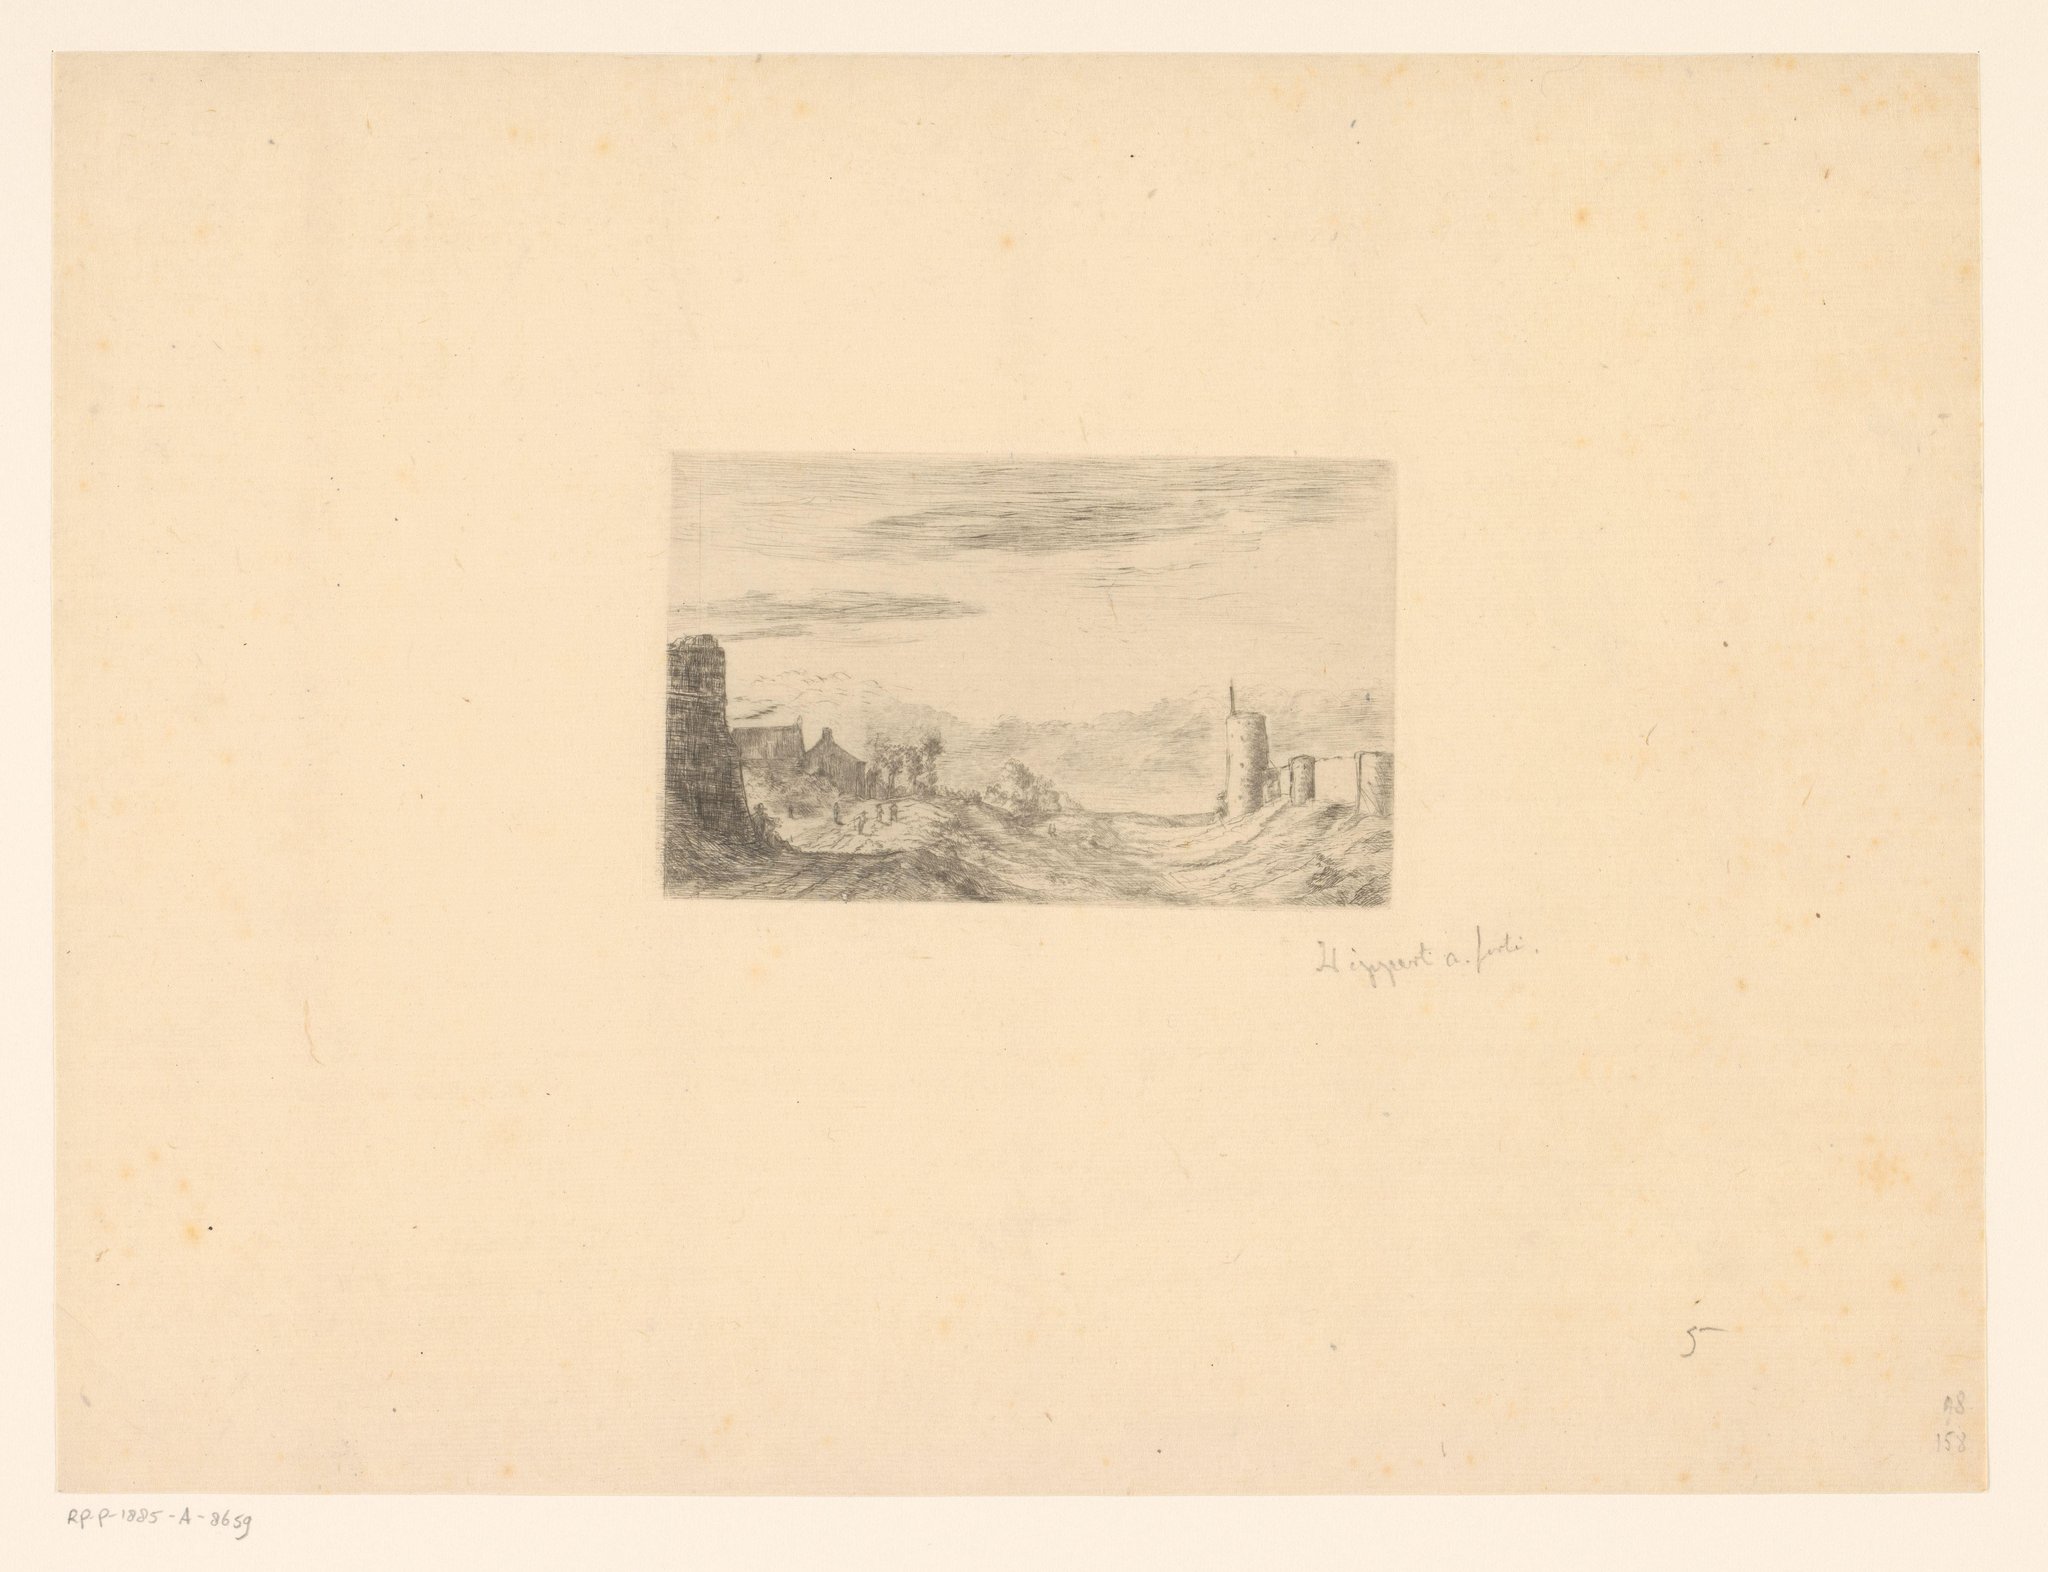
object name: print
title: Landschap met ruïne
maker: karel theodoor hippert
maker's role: print maker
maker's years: 1839-1919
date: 1849-1885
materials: paper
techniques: etching, intaglio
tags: landscape with ruins (+ city(-scape) with figures, staffage)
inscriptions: collector's mark: Lugt 2228